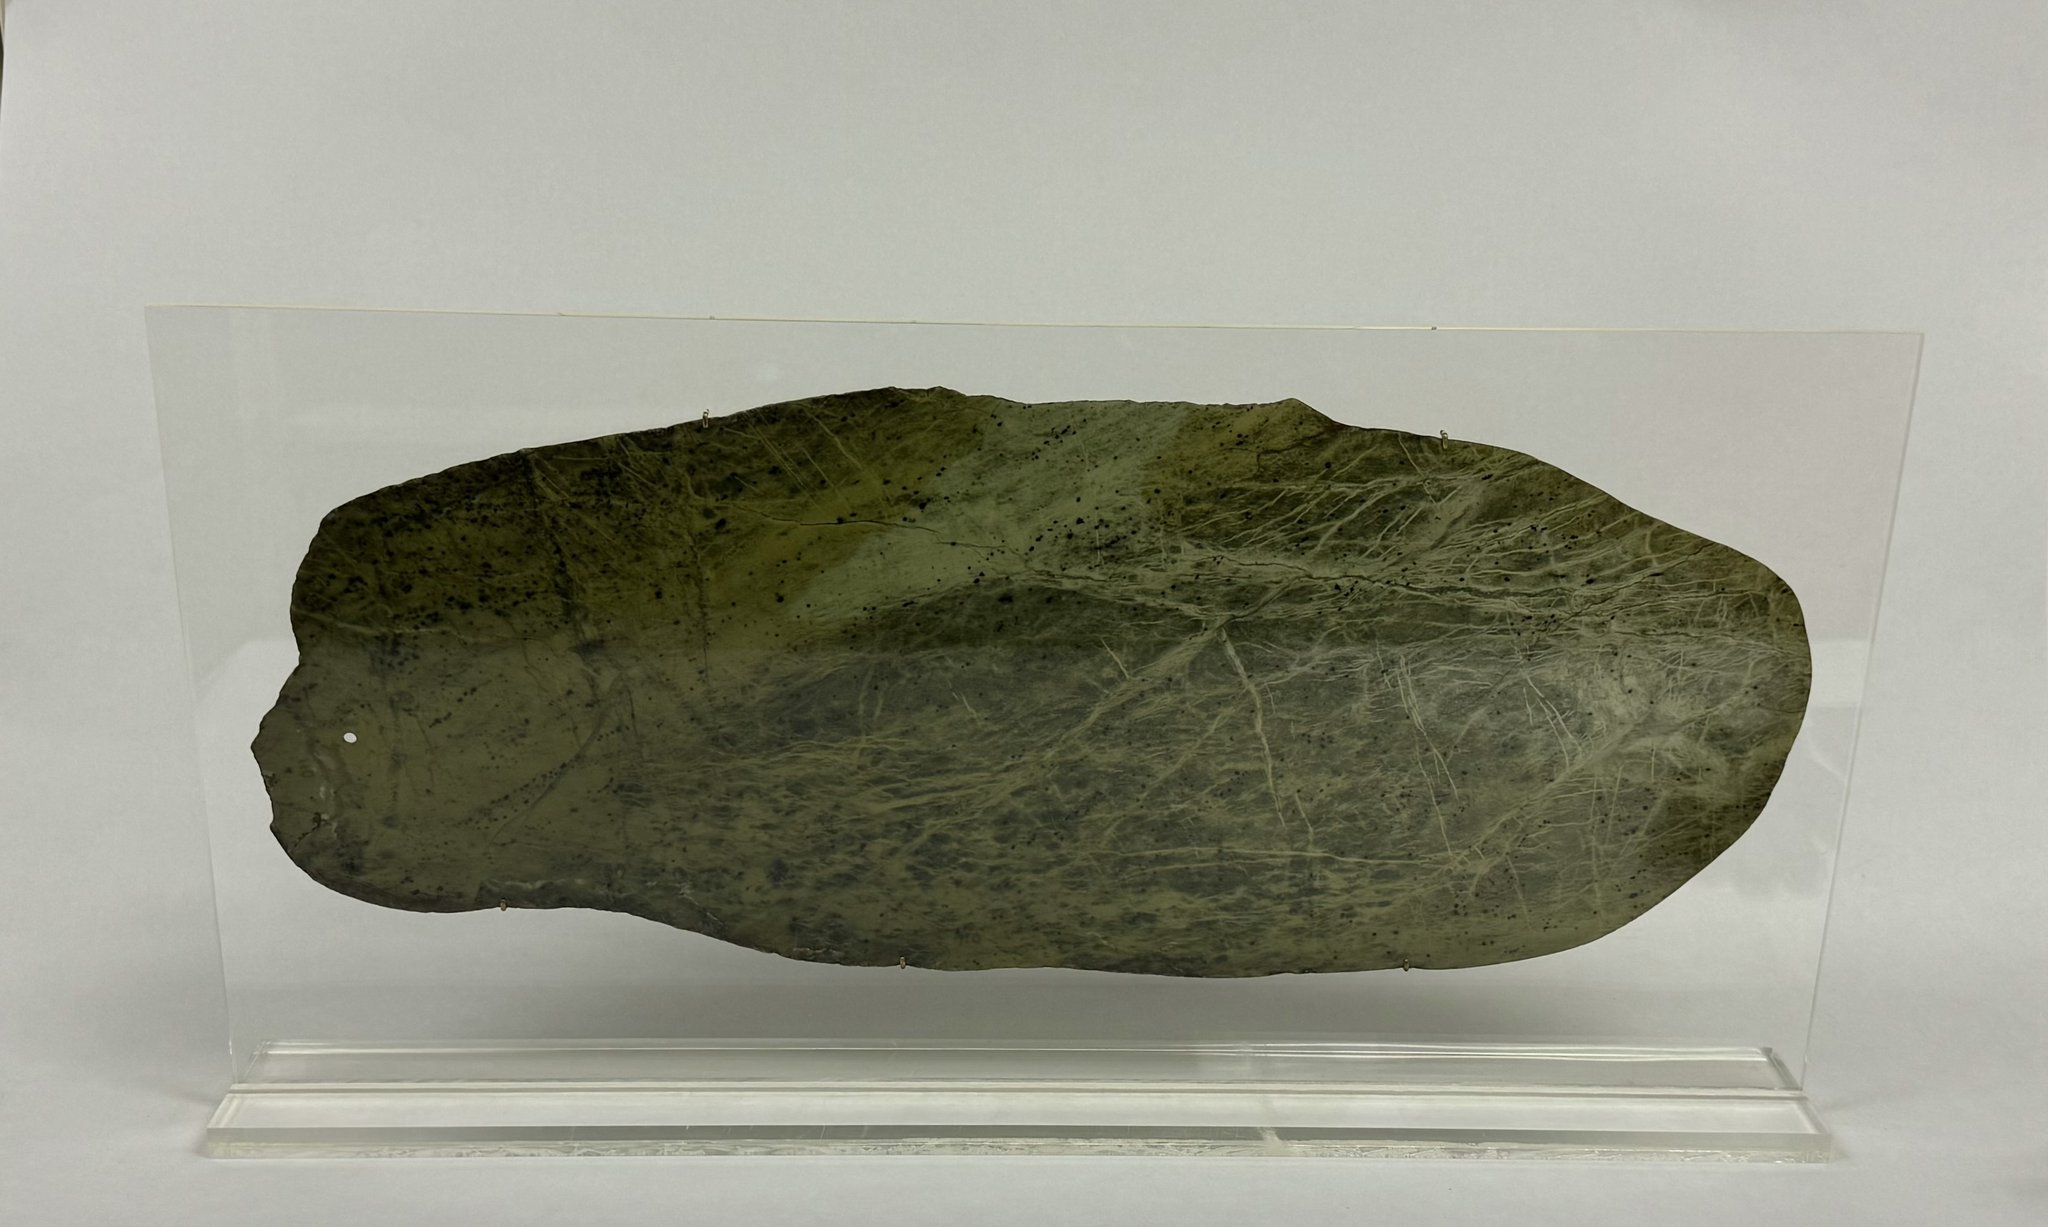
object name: fragment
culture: russian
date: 1902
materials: jade